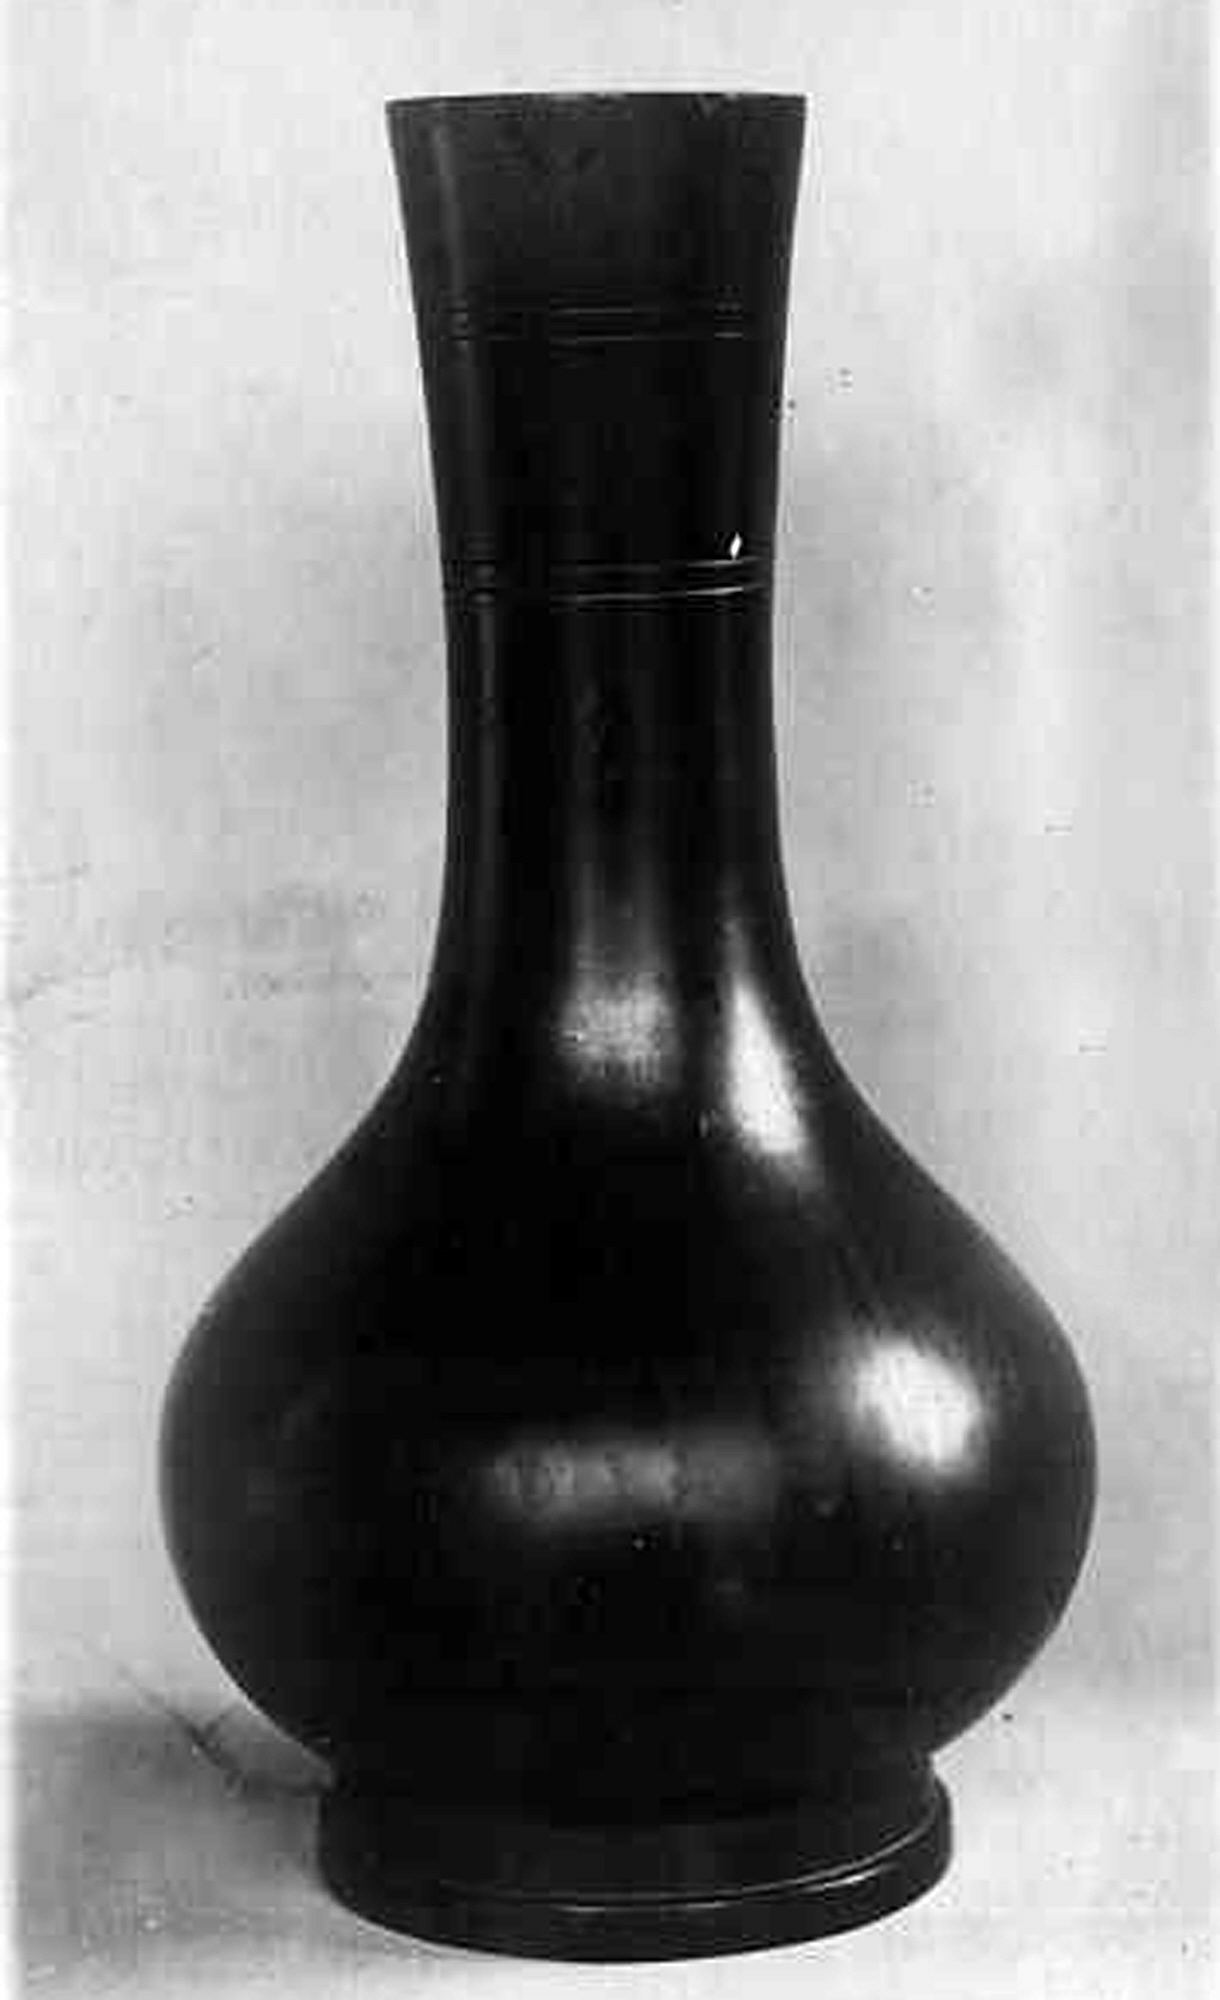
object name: vase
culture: japanese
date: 1734-1900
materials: bronze